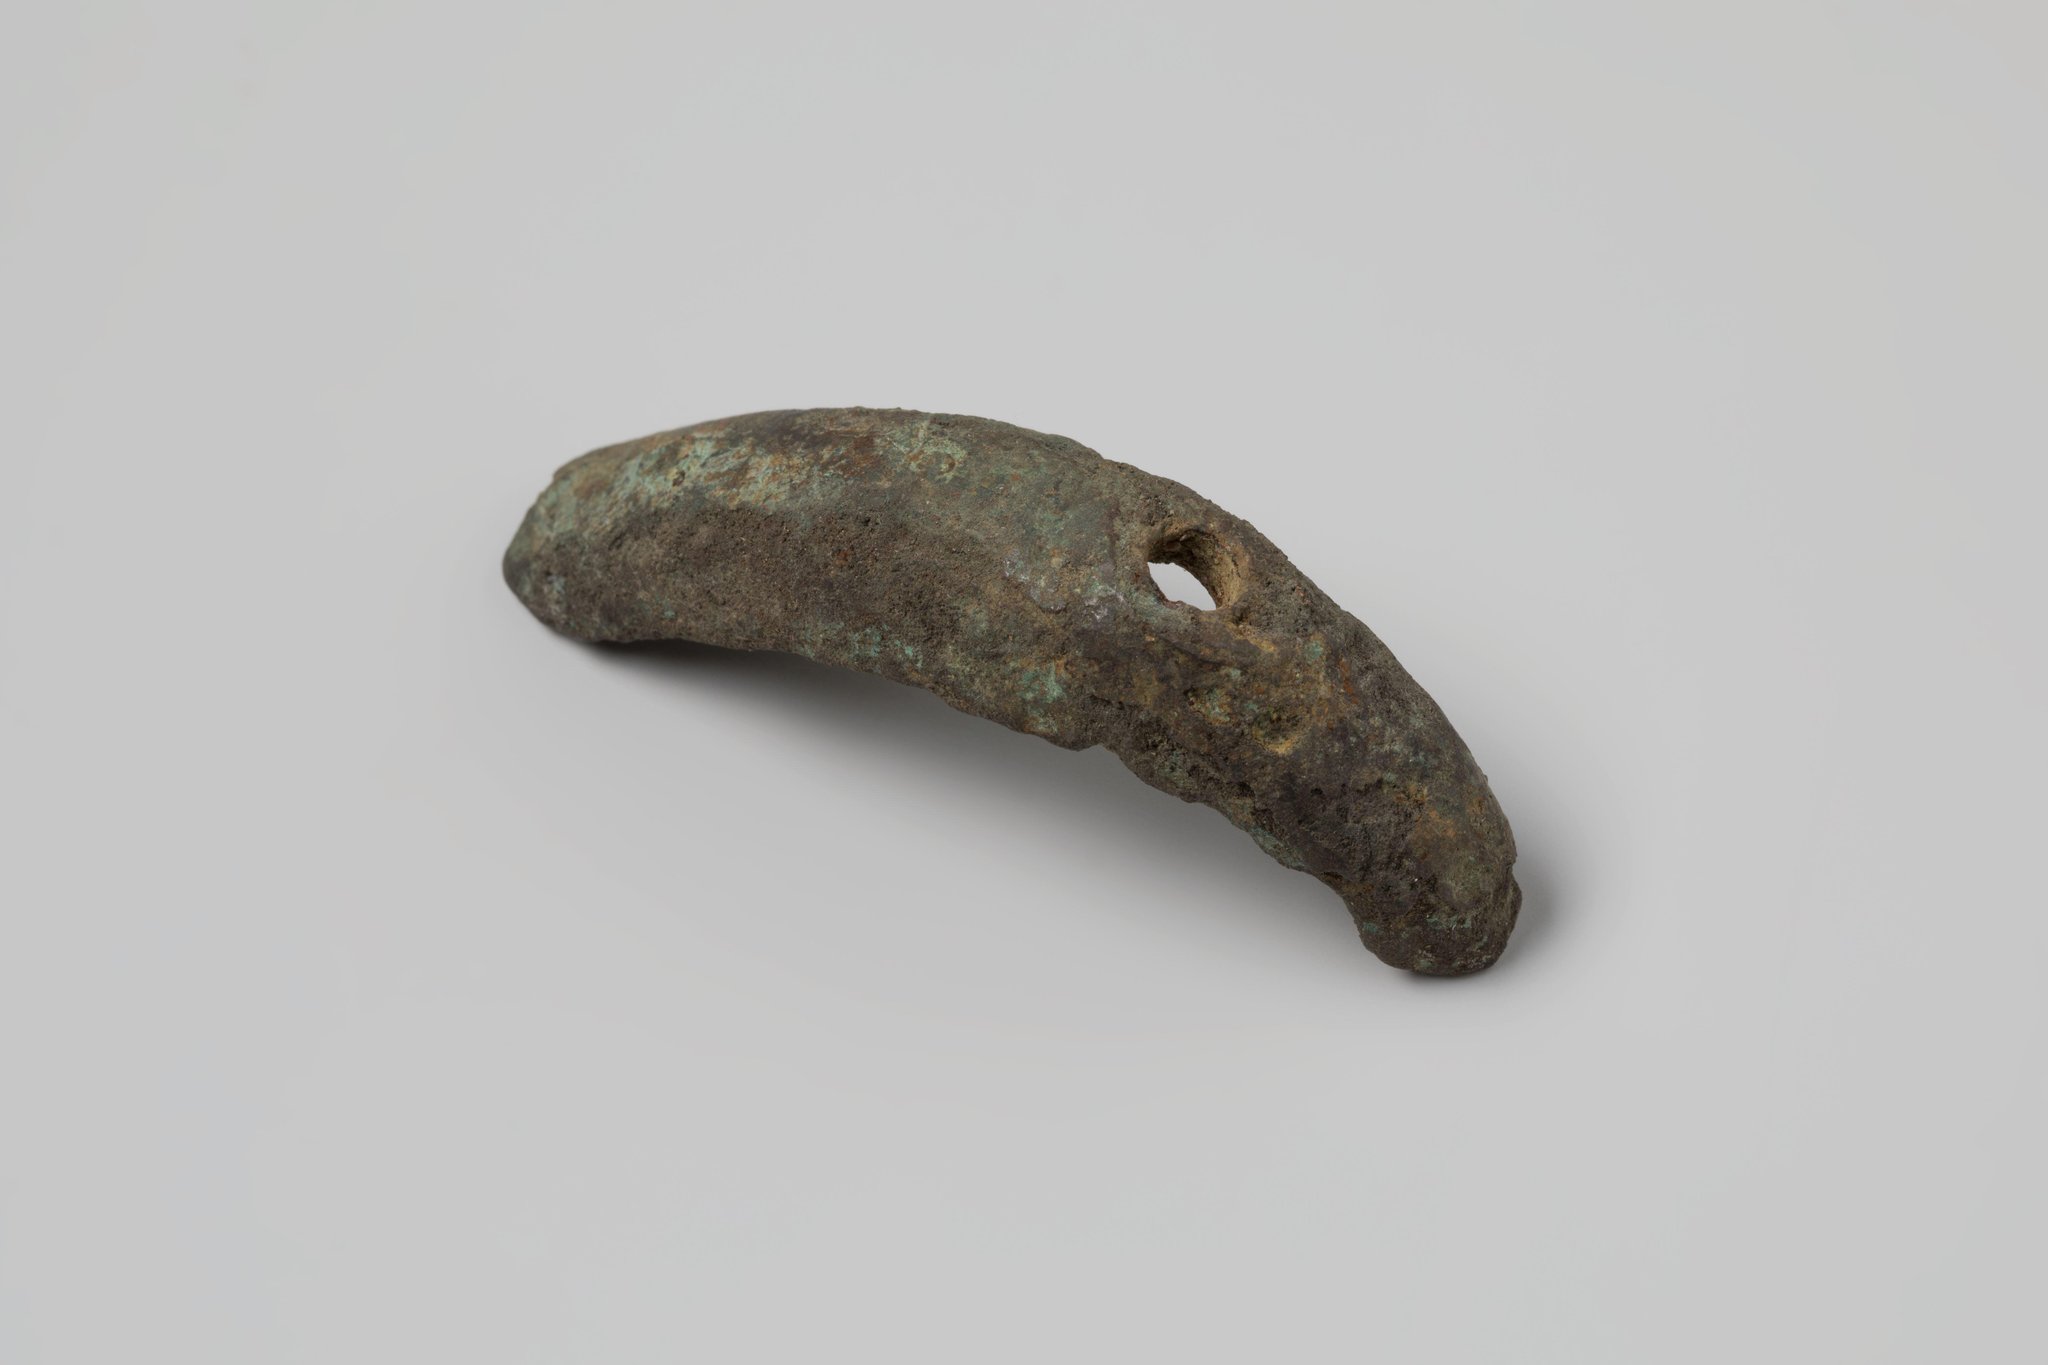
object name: beslag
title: Hoekbeslag uit het wrak van de Oost-Indiëvaarder Hollandia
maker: Anonymous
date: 1700-1743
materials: copper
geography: netherlands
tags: verenigde oostindische compagnie, hollandia (schip), annet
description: Corner-fitting; eroded: curved, semicircular in section, concave inside, tapering ends, circular hole in apex of curve.